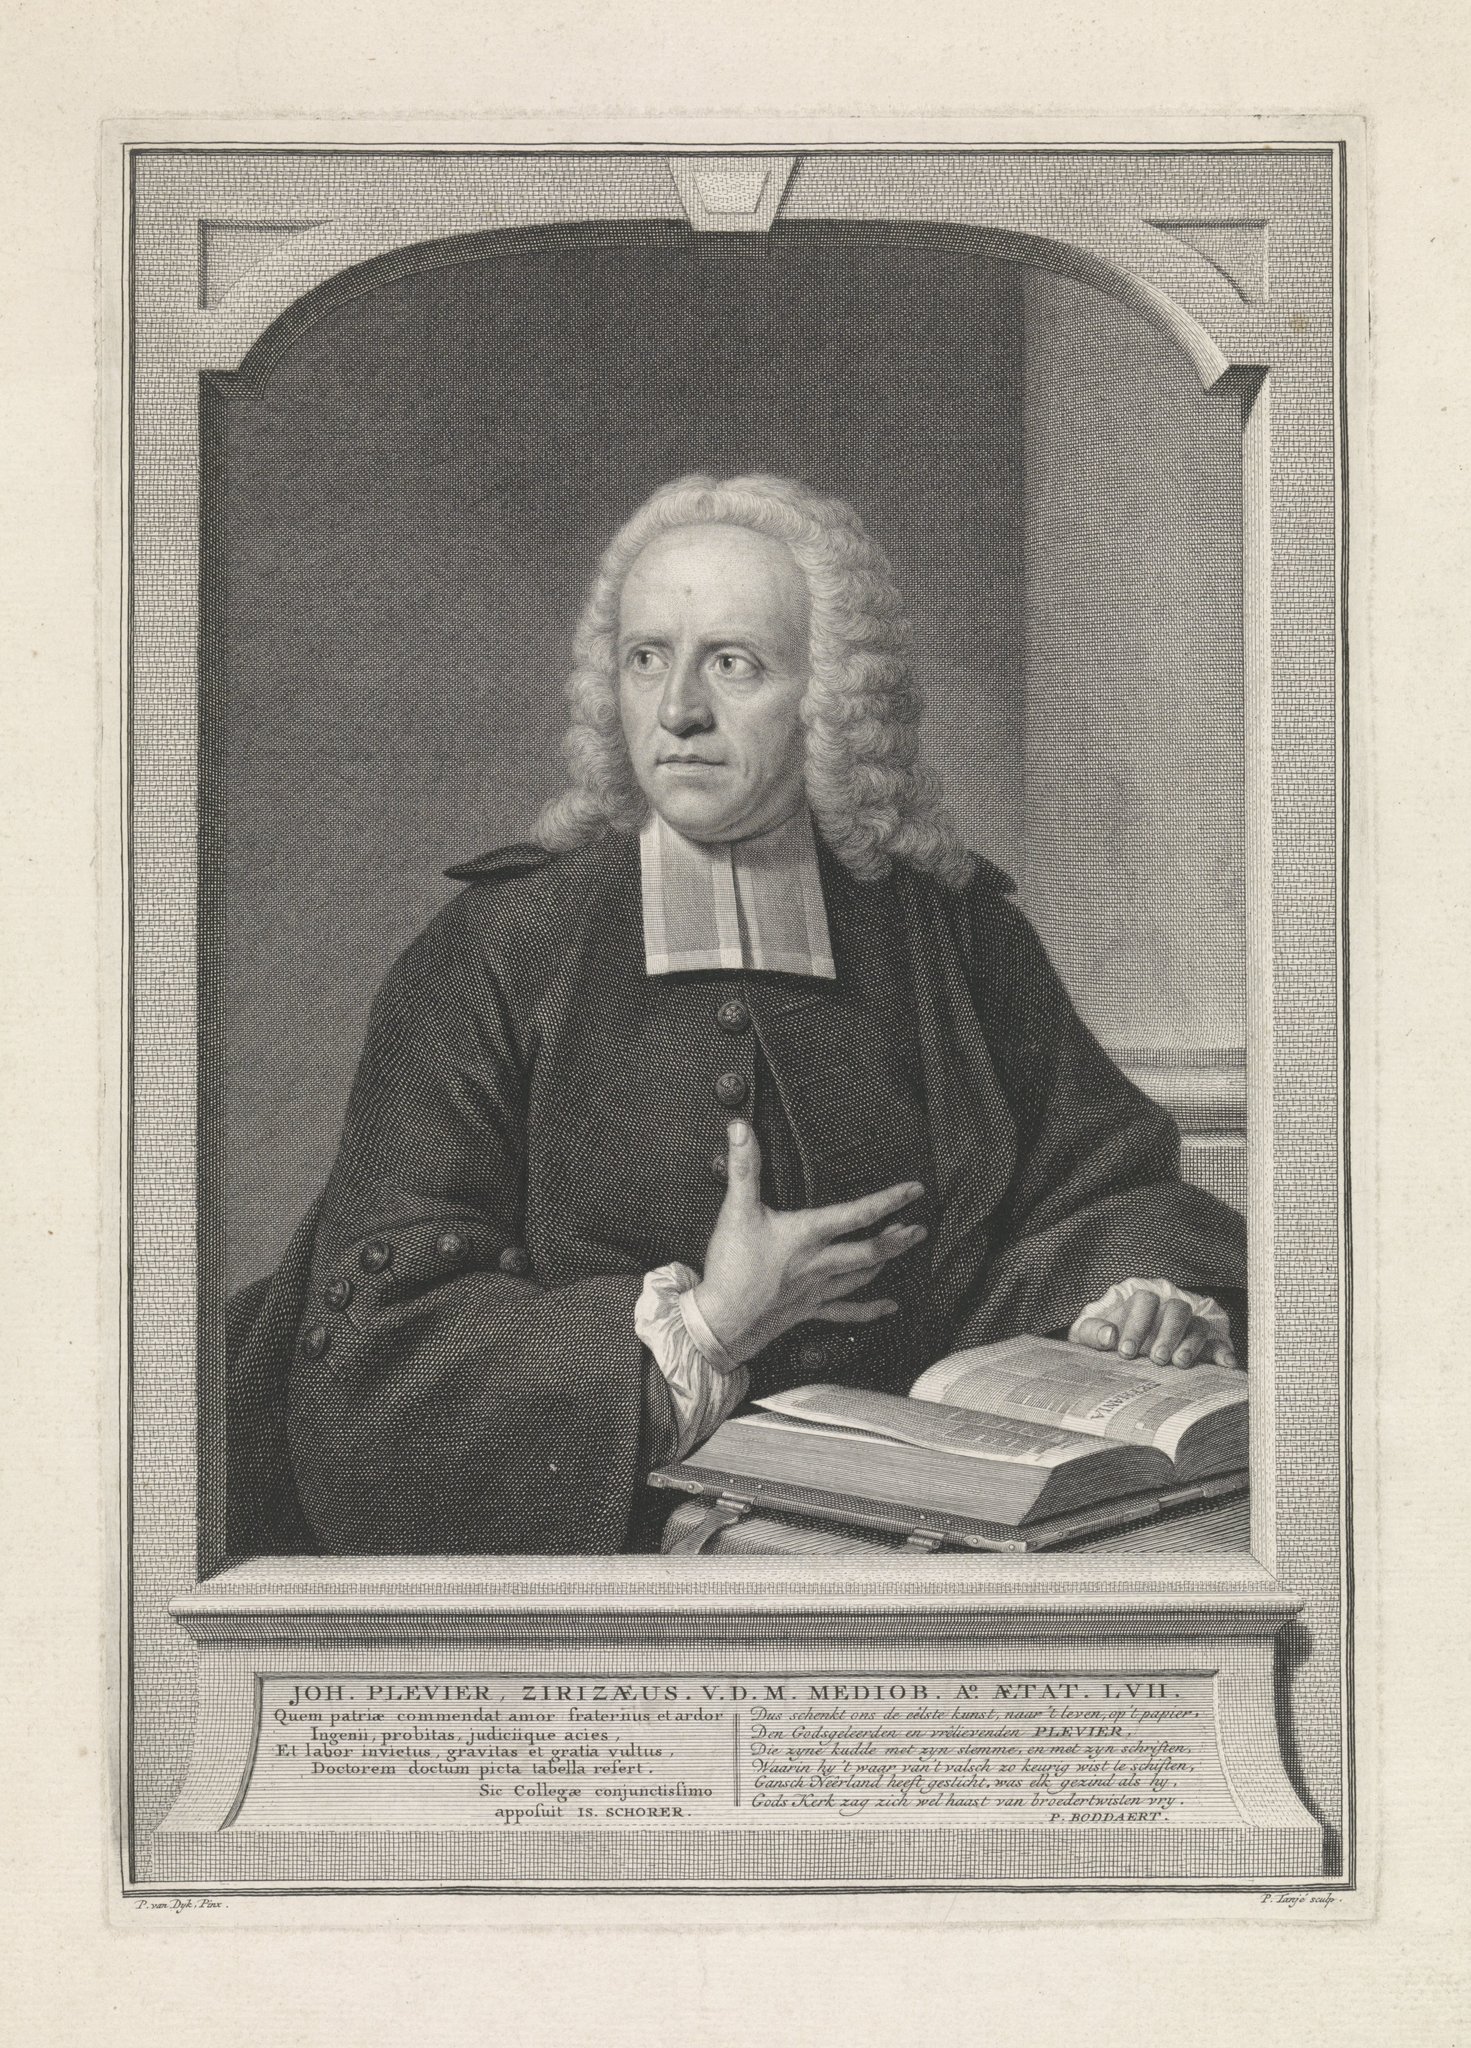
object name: print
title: Portret van Johannes Plevier op 57-jarige leeftijd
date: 1742-1761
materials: paper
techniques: engraving, etching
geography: amsterdam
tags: middelburg, the bible as a book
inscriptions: collector's mark: Lugt 2228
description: Portret van Johannes Plevier, predikant te Middelburg, op 57-jarige leeftijd, bij een opengeslagen Bijbel.